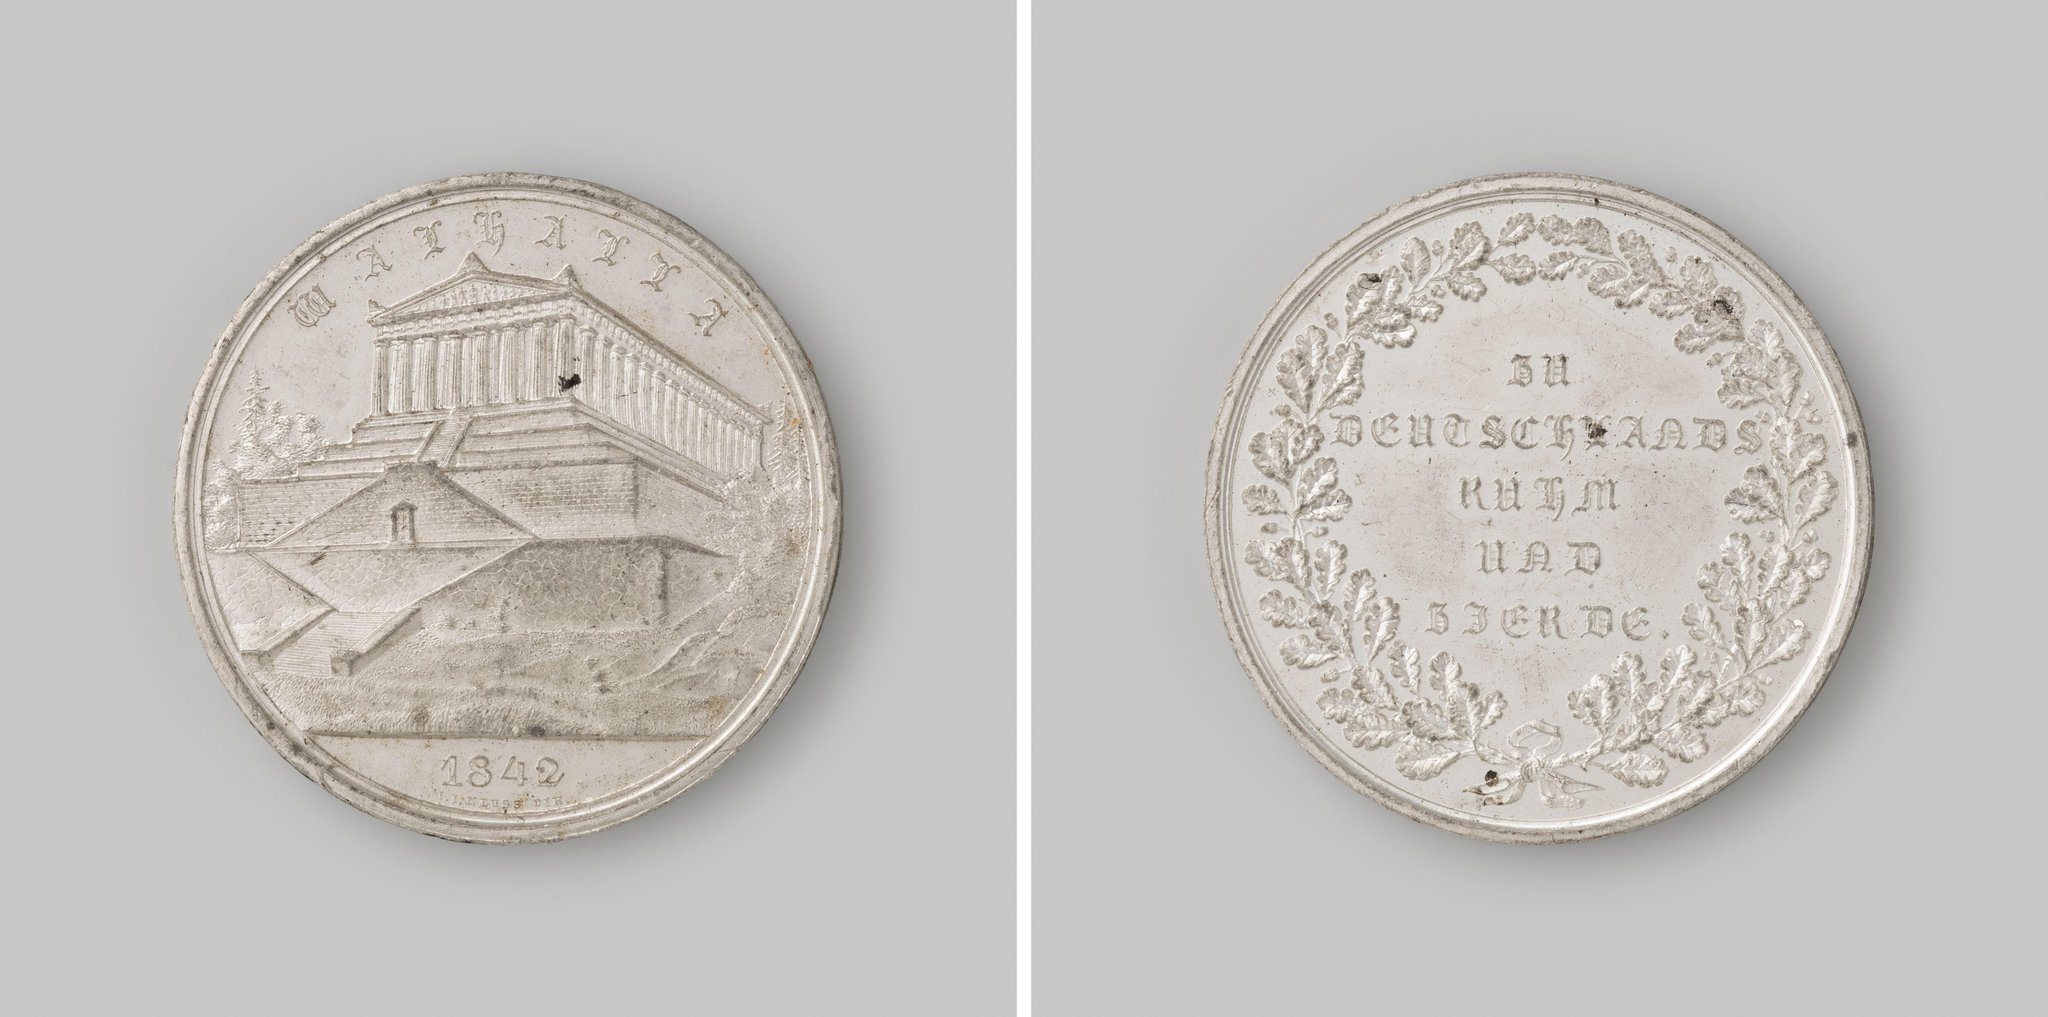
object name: history medal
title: Inwijding van het Walhalla bij Regensburg in Beieren 1842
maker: johann jakob neuss (der jüngere)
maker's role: medailleur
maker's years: 1770-1847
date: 1842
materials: tin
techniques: striking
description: Tinnen penning, op de voorzijde het aanzicht van het Walhalla met omschrift en afsnedetekst, op de keerzijde vijf regels tekst tussen samengestrikte eikentakken.